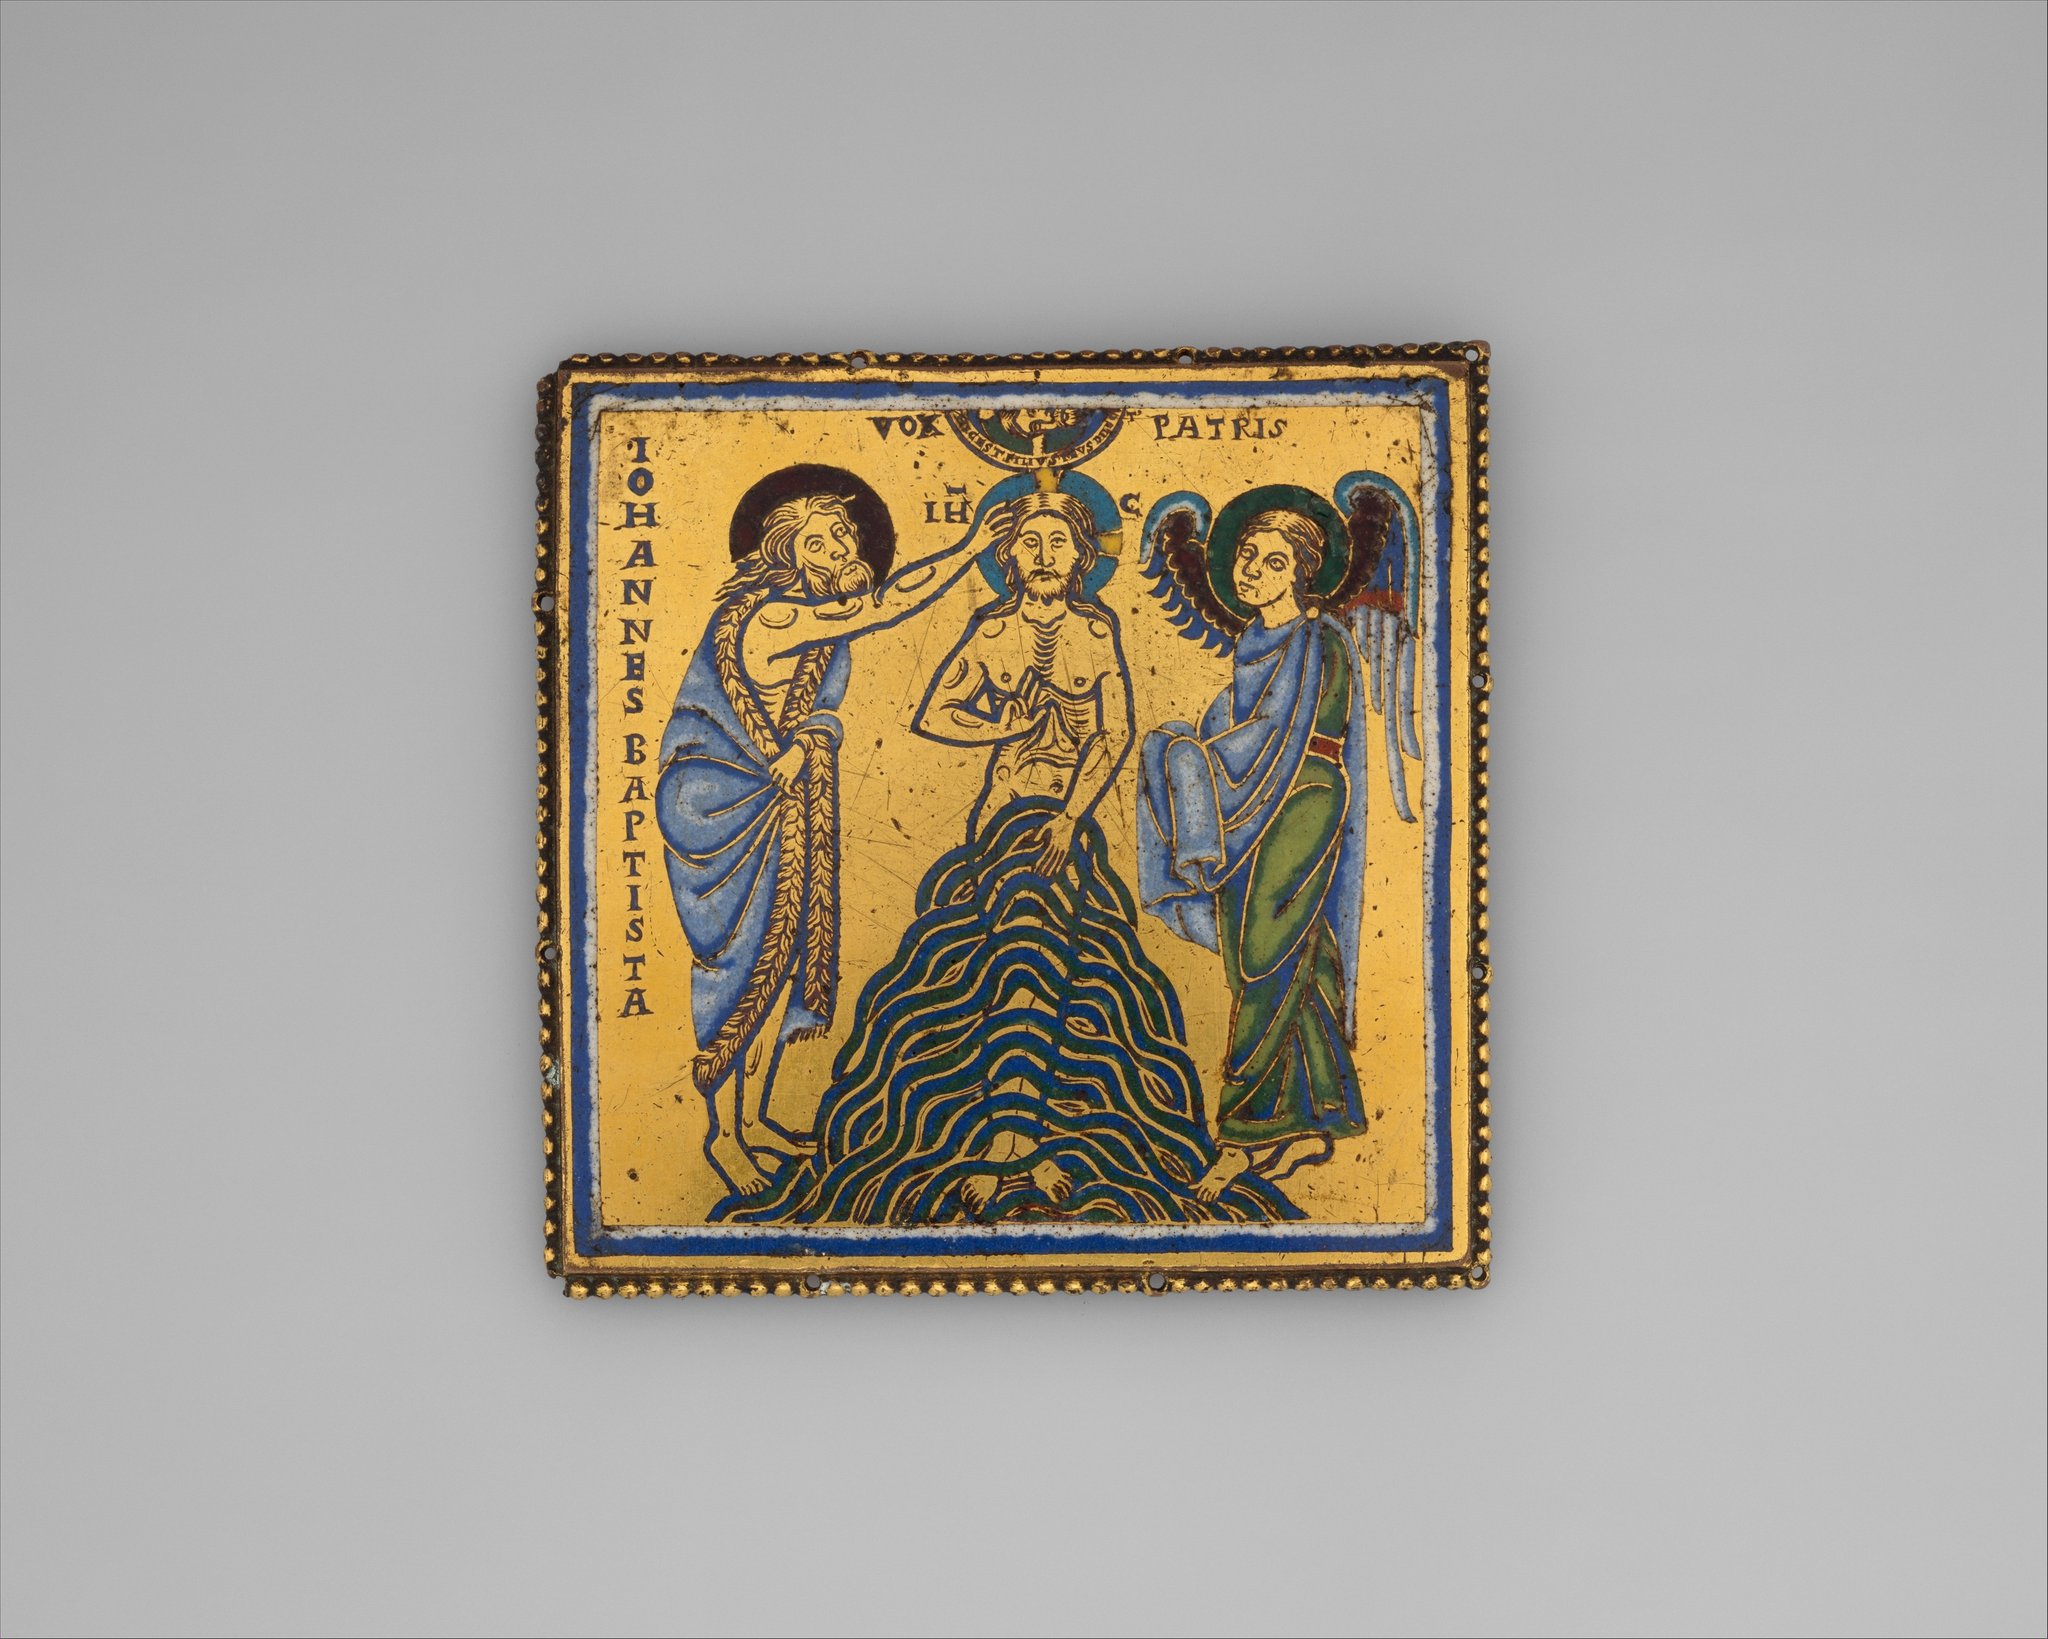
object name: plaque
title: Plaque with the Baptism of Jesus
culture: south netherlandish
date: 1150-1175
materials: copper alloy, enamel, gilt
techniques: enamel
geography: netherlands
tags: angels,jesus,saints